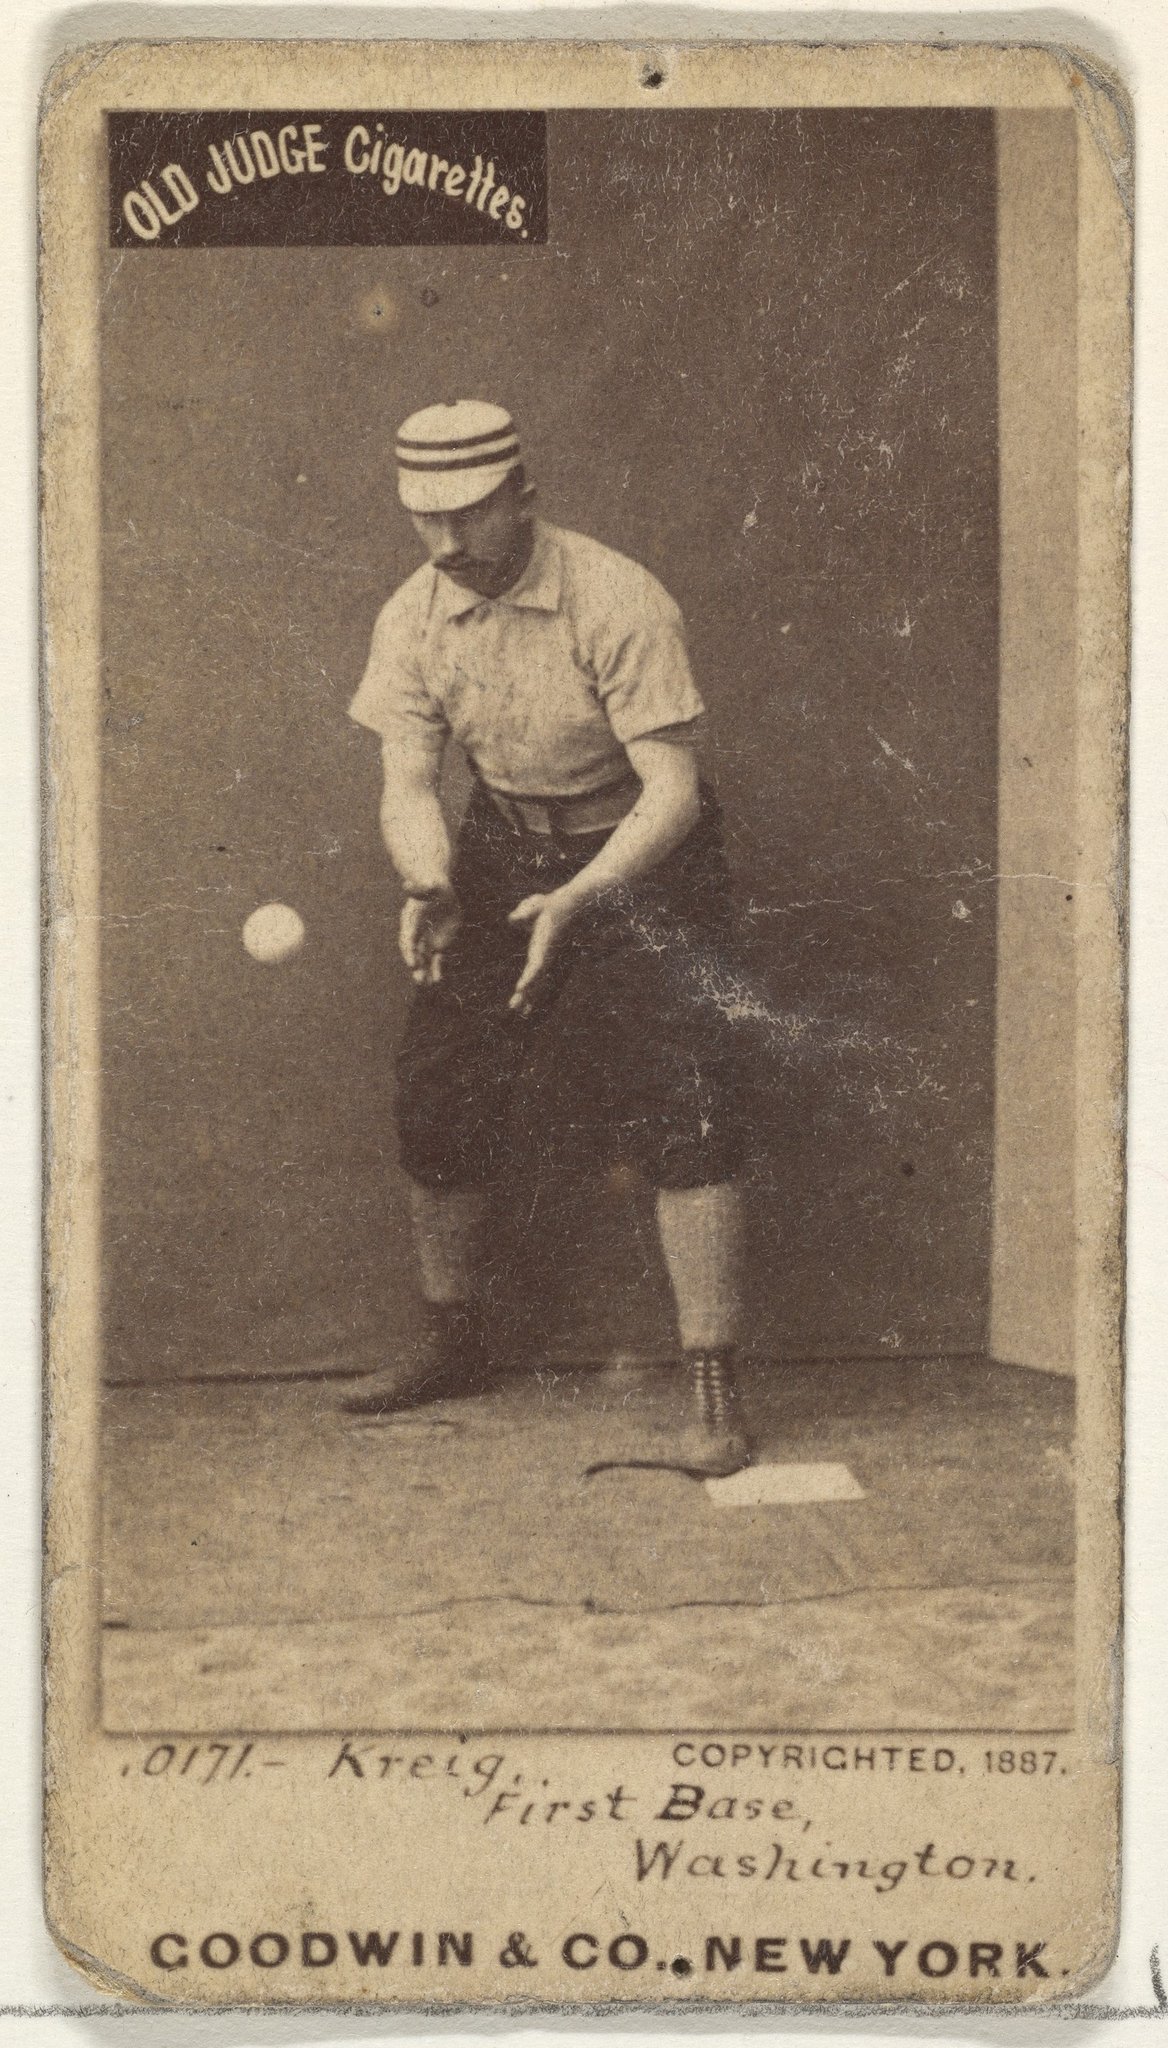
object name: baseball card, photograph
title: William "Bill" Frederick Krieg, 1st Base, Washington Nationals, from the Old Judge series (N172) for Old Judge Cigarettes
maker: goodwin & company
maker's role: publisher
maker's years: 1850-1950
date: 1887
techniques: albumen silver print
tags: men,portraits,baseball,athletes